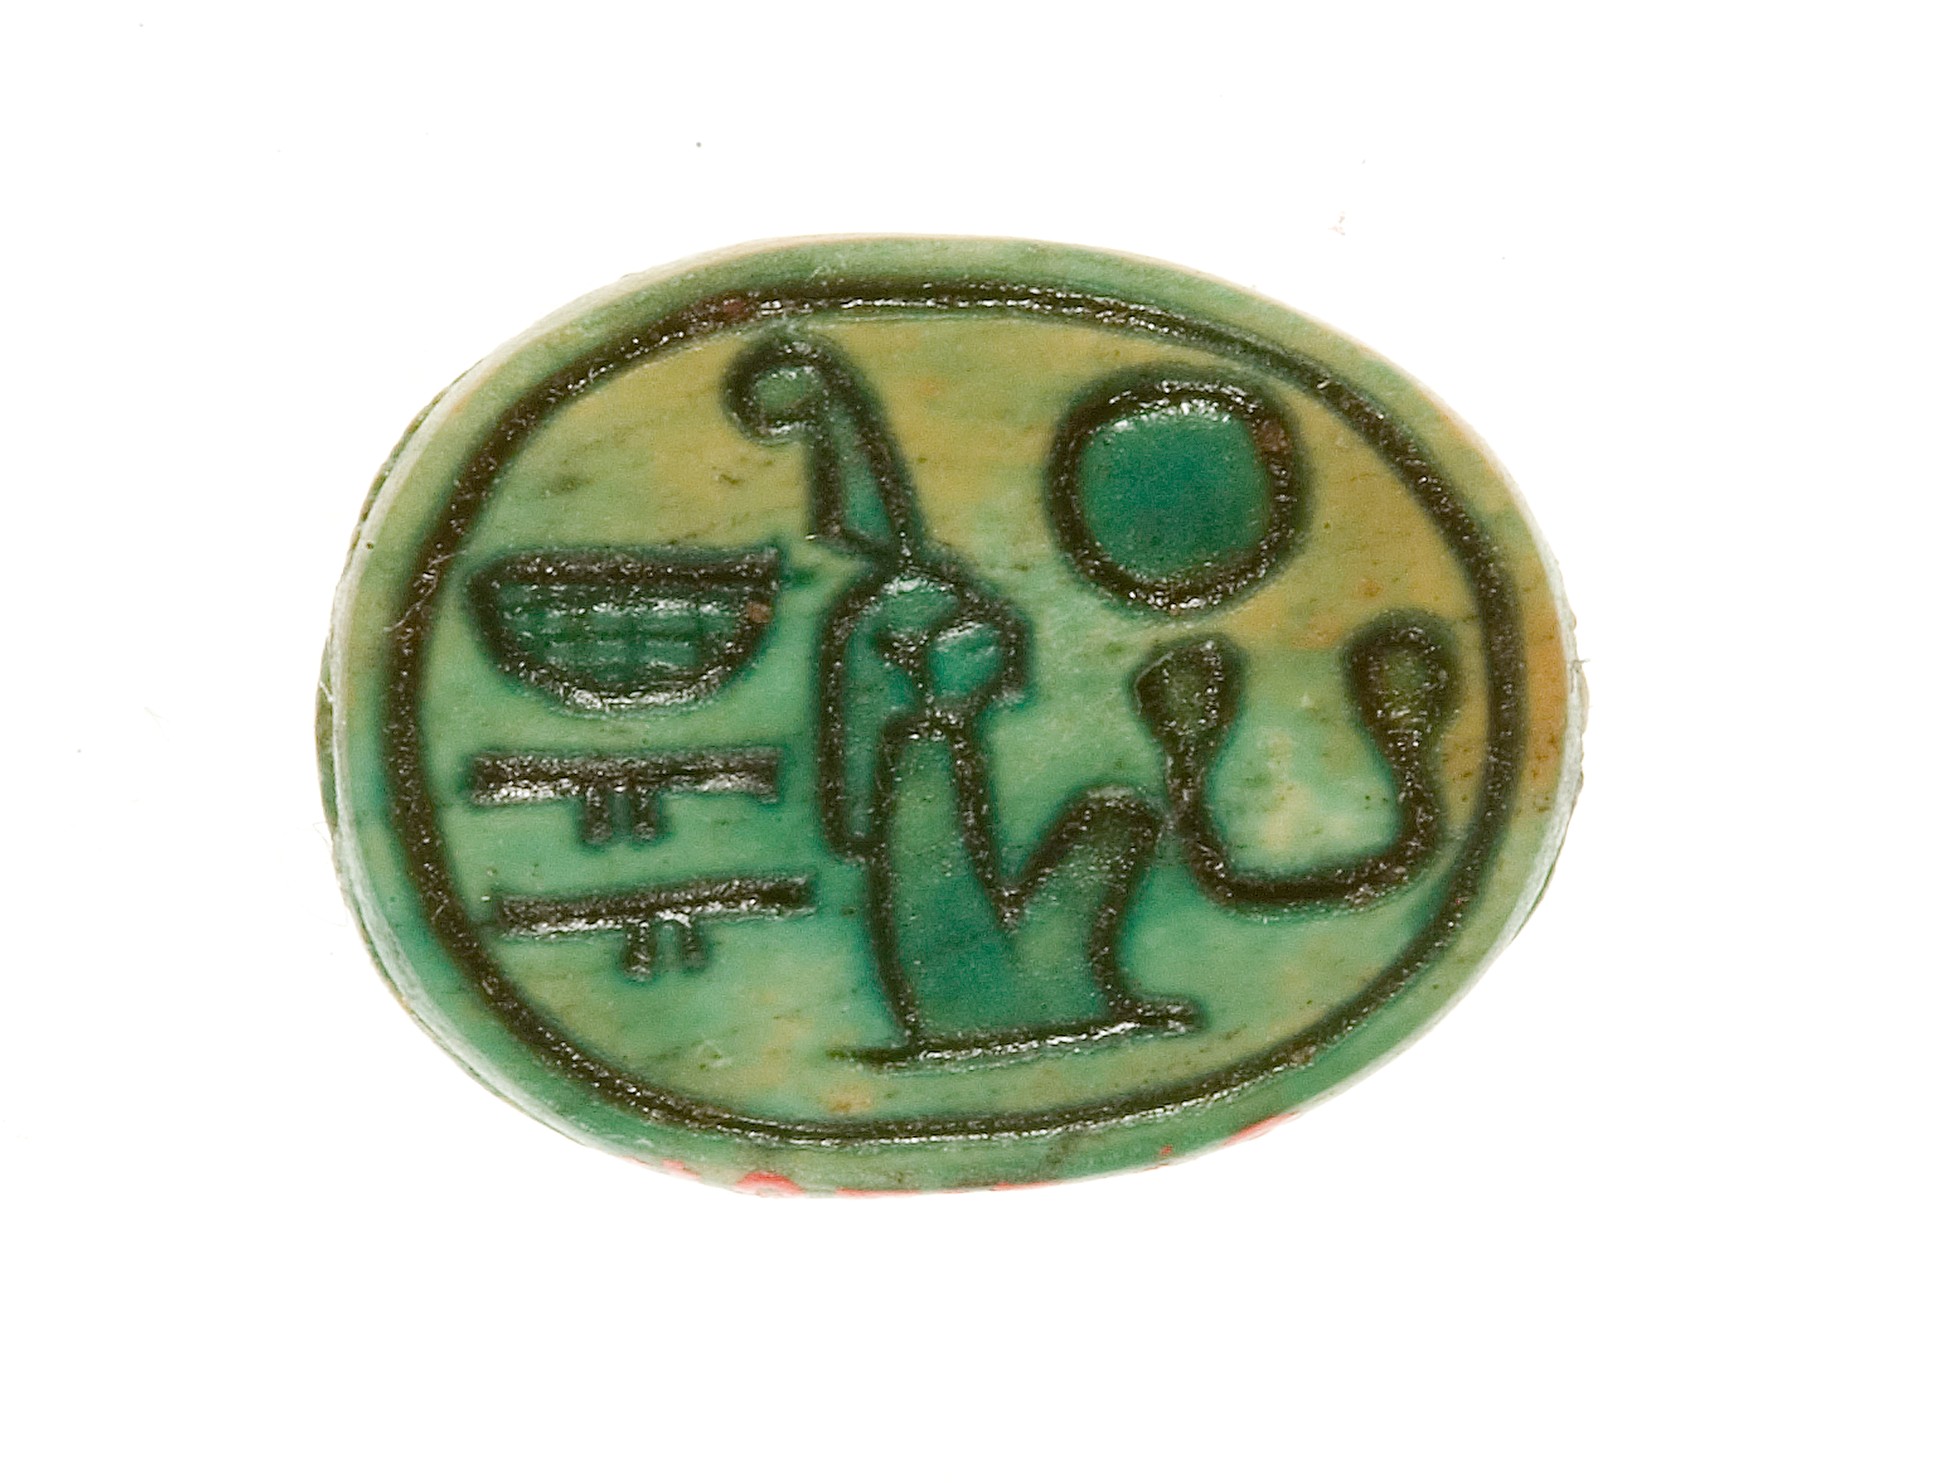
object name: scarab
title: Scarab Inscribed Lord of the Two Lands Maatkare (Hatshepsut)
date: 1479-1458 BCE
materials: stone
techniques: glazing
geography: egypt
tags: scarabs